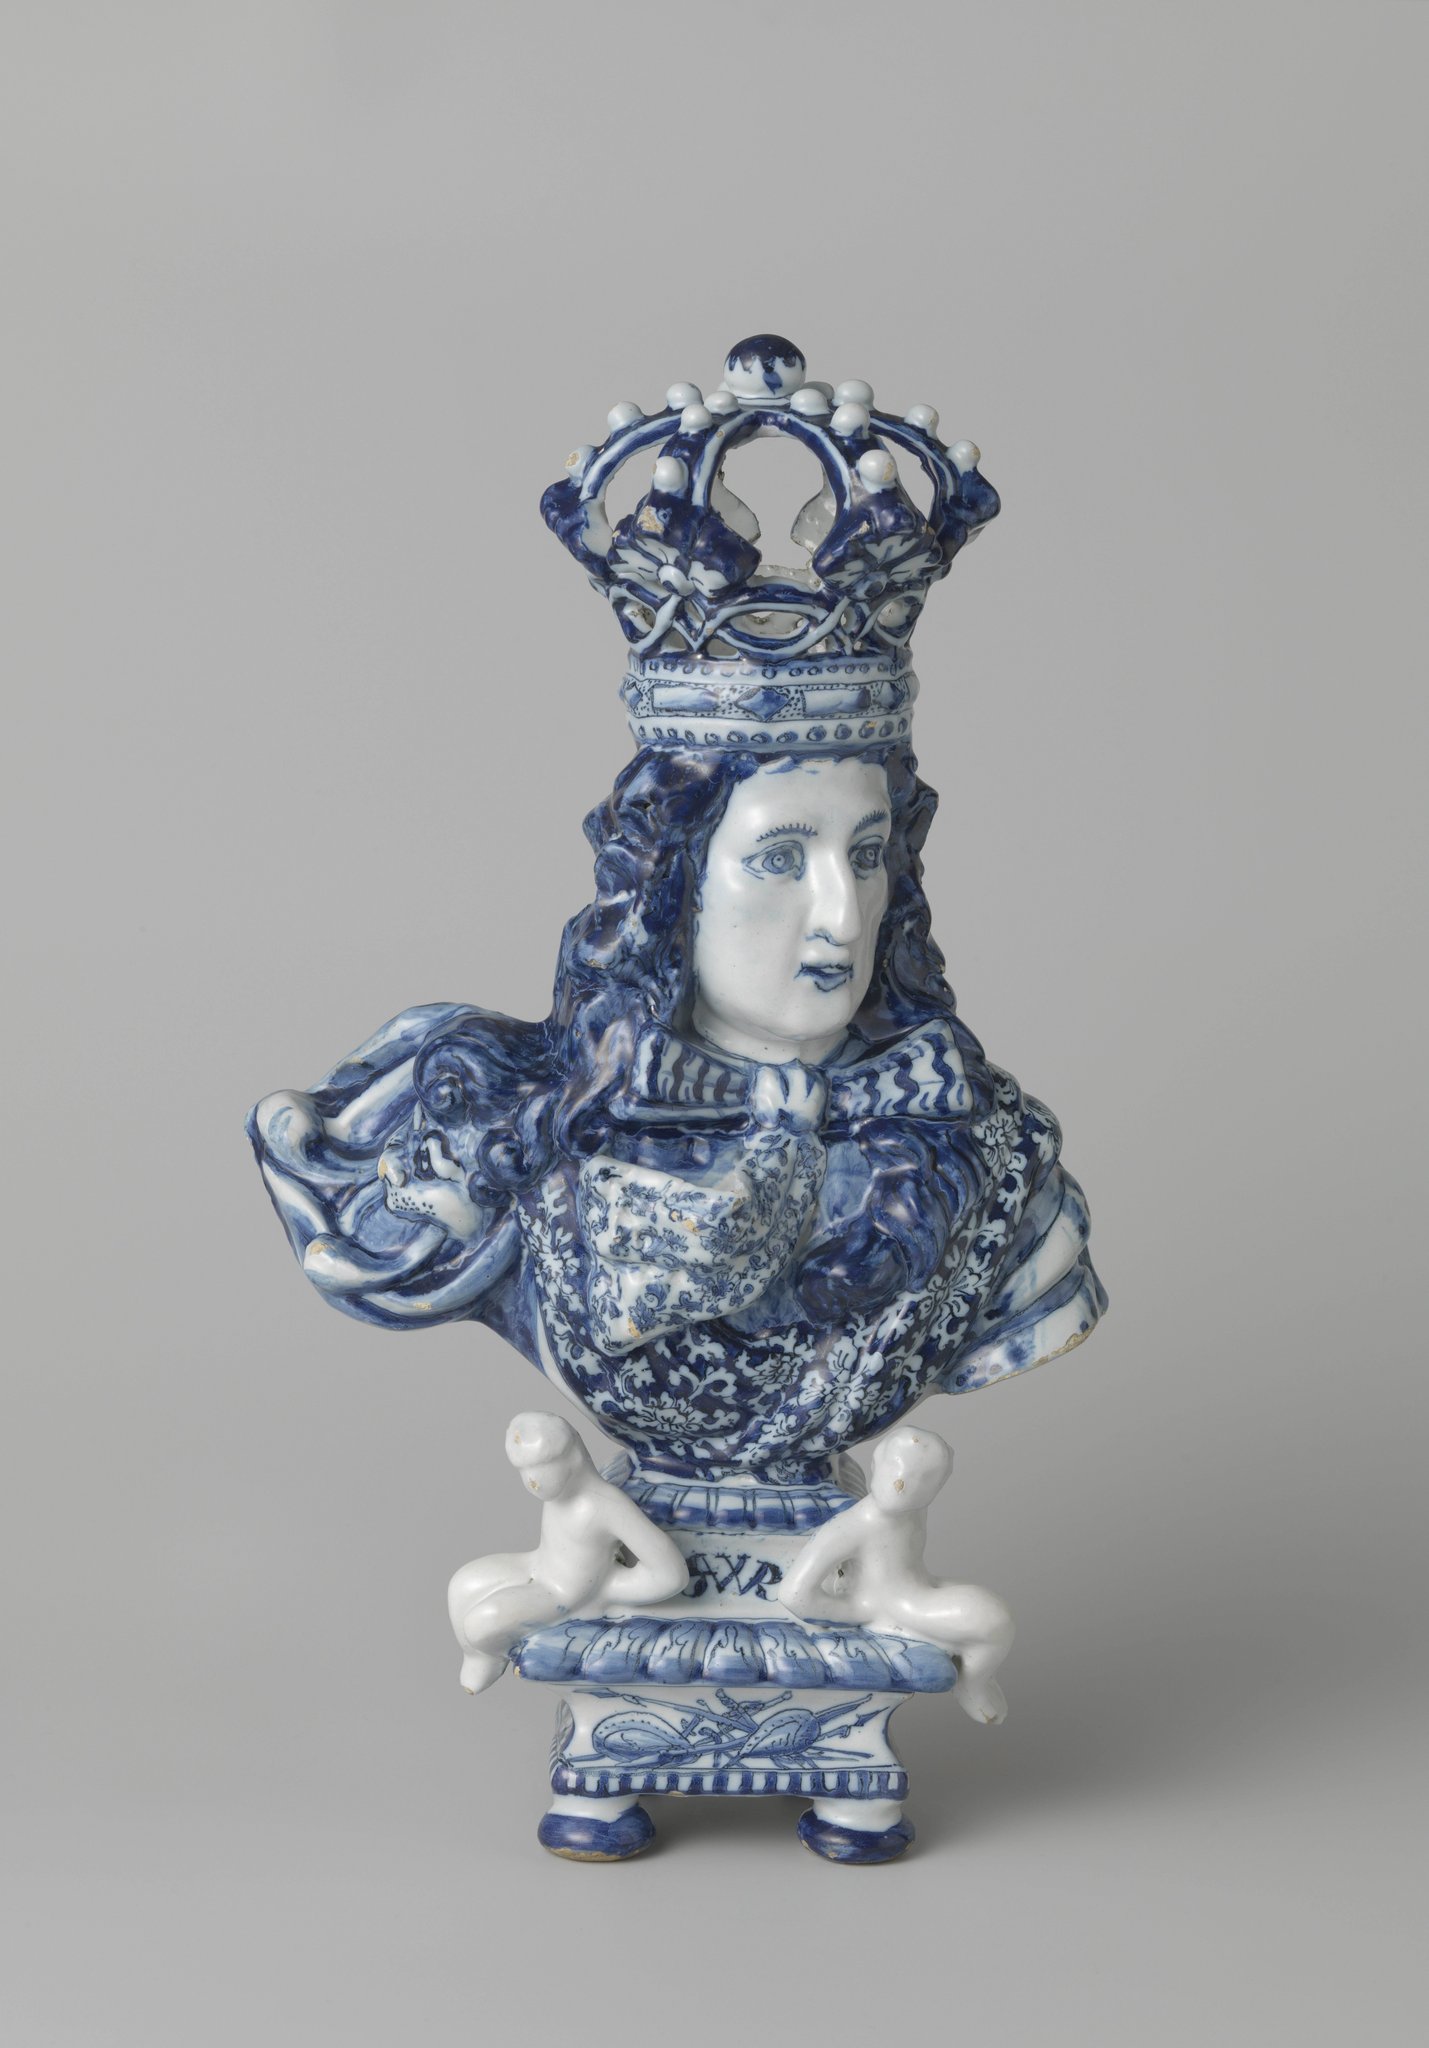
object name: bust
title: Bust of King-Stadtholder William III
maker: lambertus van eenhoorn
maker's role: plateelbakker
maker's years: 1651-1721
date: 1695-1700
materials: earthenware, glaze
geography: delft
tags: the hague, william iii (prince of orange and king of england, scotland, and ireland), historical persons (+ (full) bust portrait), king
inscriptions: inscription: ‘spiegelmonogram WR (William Rex)’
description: After De Metaale Pot hired a French modeller, it succeeded in becoming the first pottery factory in the Netherlands to produce large sculptural earthenware objects. The modeller’s influence is visible in the way in which the drapery folds around the shoulders of this portrait bust are rendered.